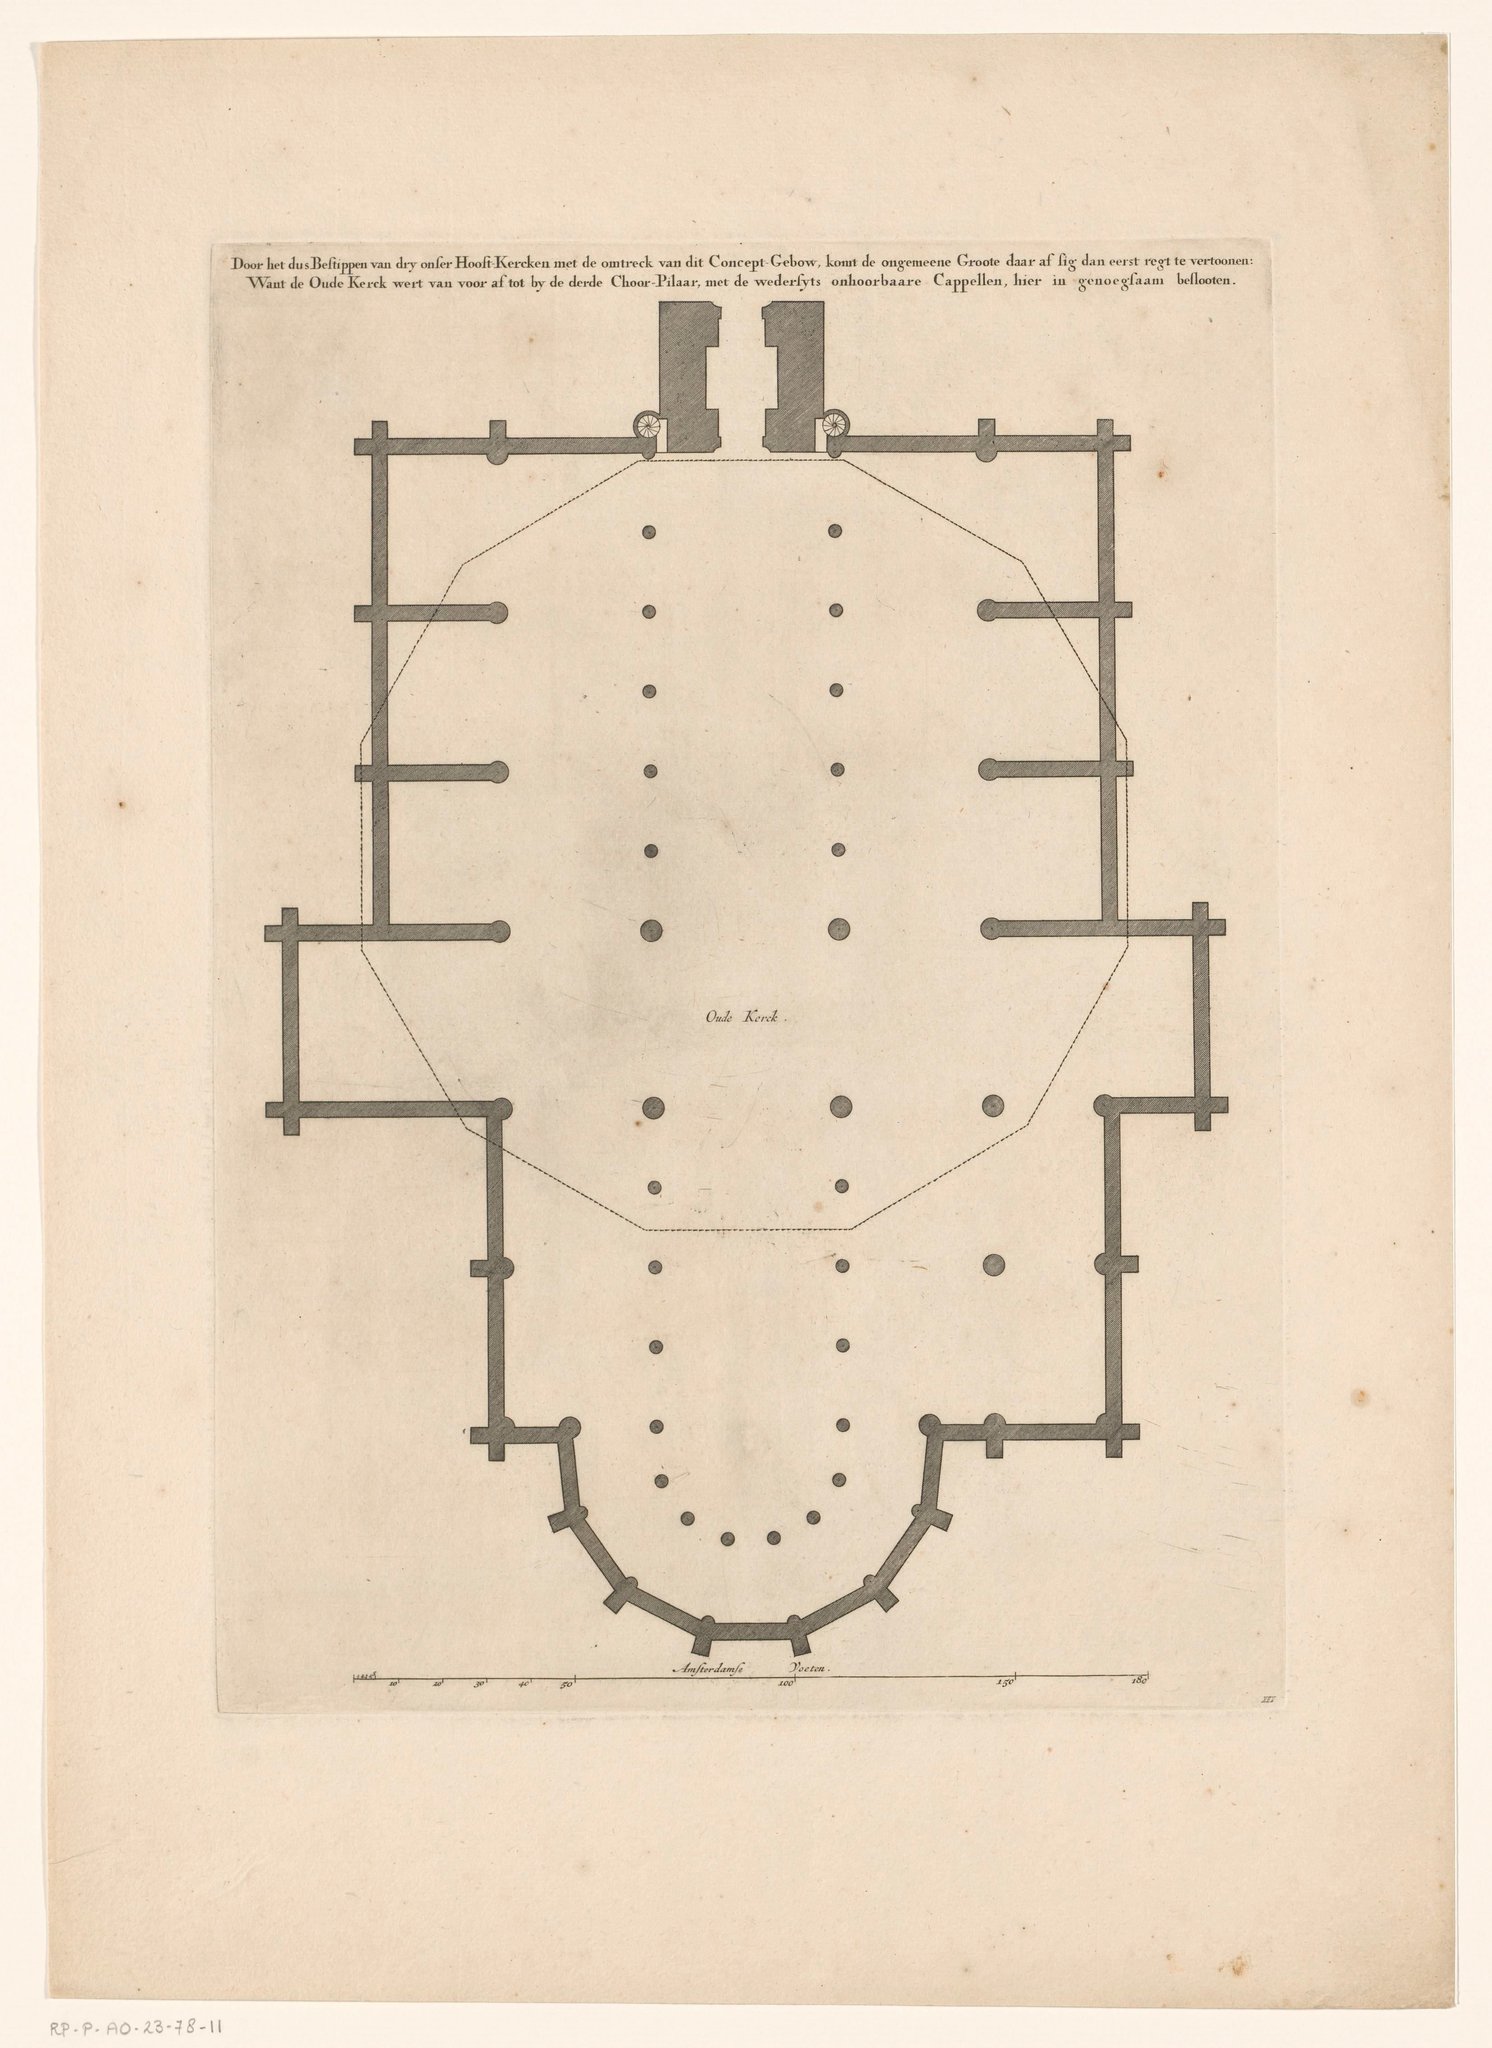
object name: area plan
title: Plattegronden van de Oude Kerk met omtrek van het ontwerp voor een koepelkerk op de Botermarkt te Amsterdam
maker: daniël stopendaal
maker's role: print maker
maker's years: 1672-1726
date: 1700-1705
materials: paper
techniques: engraving, etching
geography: amsterdam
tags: church (exterior), interior of church, architectural design or model, plan ~ architecture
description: Notaris, advocaat en kerkmeester van de Oude Kerk Nicolaas Listingh maakte rond 1700 een ontwerp voor een nieuwe koepelkerk op de Botermarkt (het huidige Rembrandtplein). Naast een houten maquette, die nog steeds te zien is in de Oude Kerk, liet hij ook op eigen kosten een serie van zeventien prenten van zijn ontwerp maken ('Nievv desseyn tot een Seer Groote, Stercke, en om te hooren, heel bequame Coupel-Kerck (…)'). De huidige prent is daar onderdeel van. Deze prenten zouden zijn gemaakt door Daniël Stopendaal.* *Long, Isaac le. Historische beschryvinge van de reformatie der stadt Amsterdam (…). Amsterdam: Johannes van Septeren (I), 1729, p. 572.